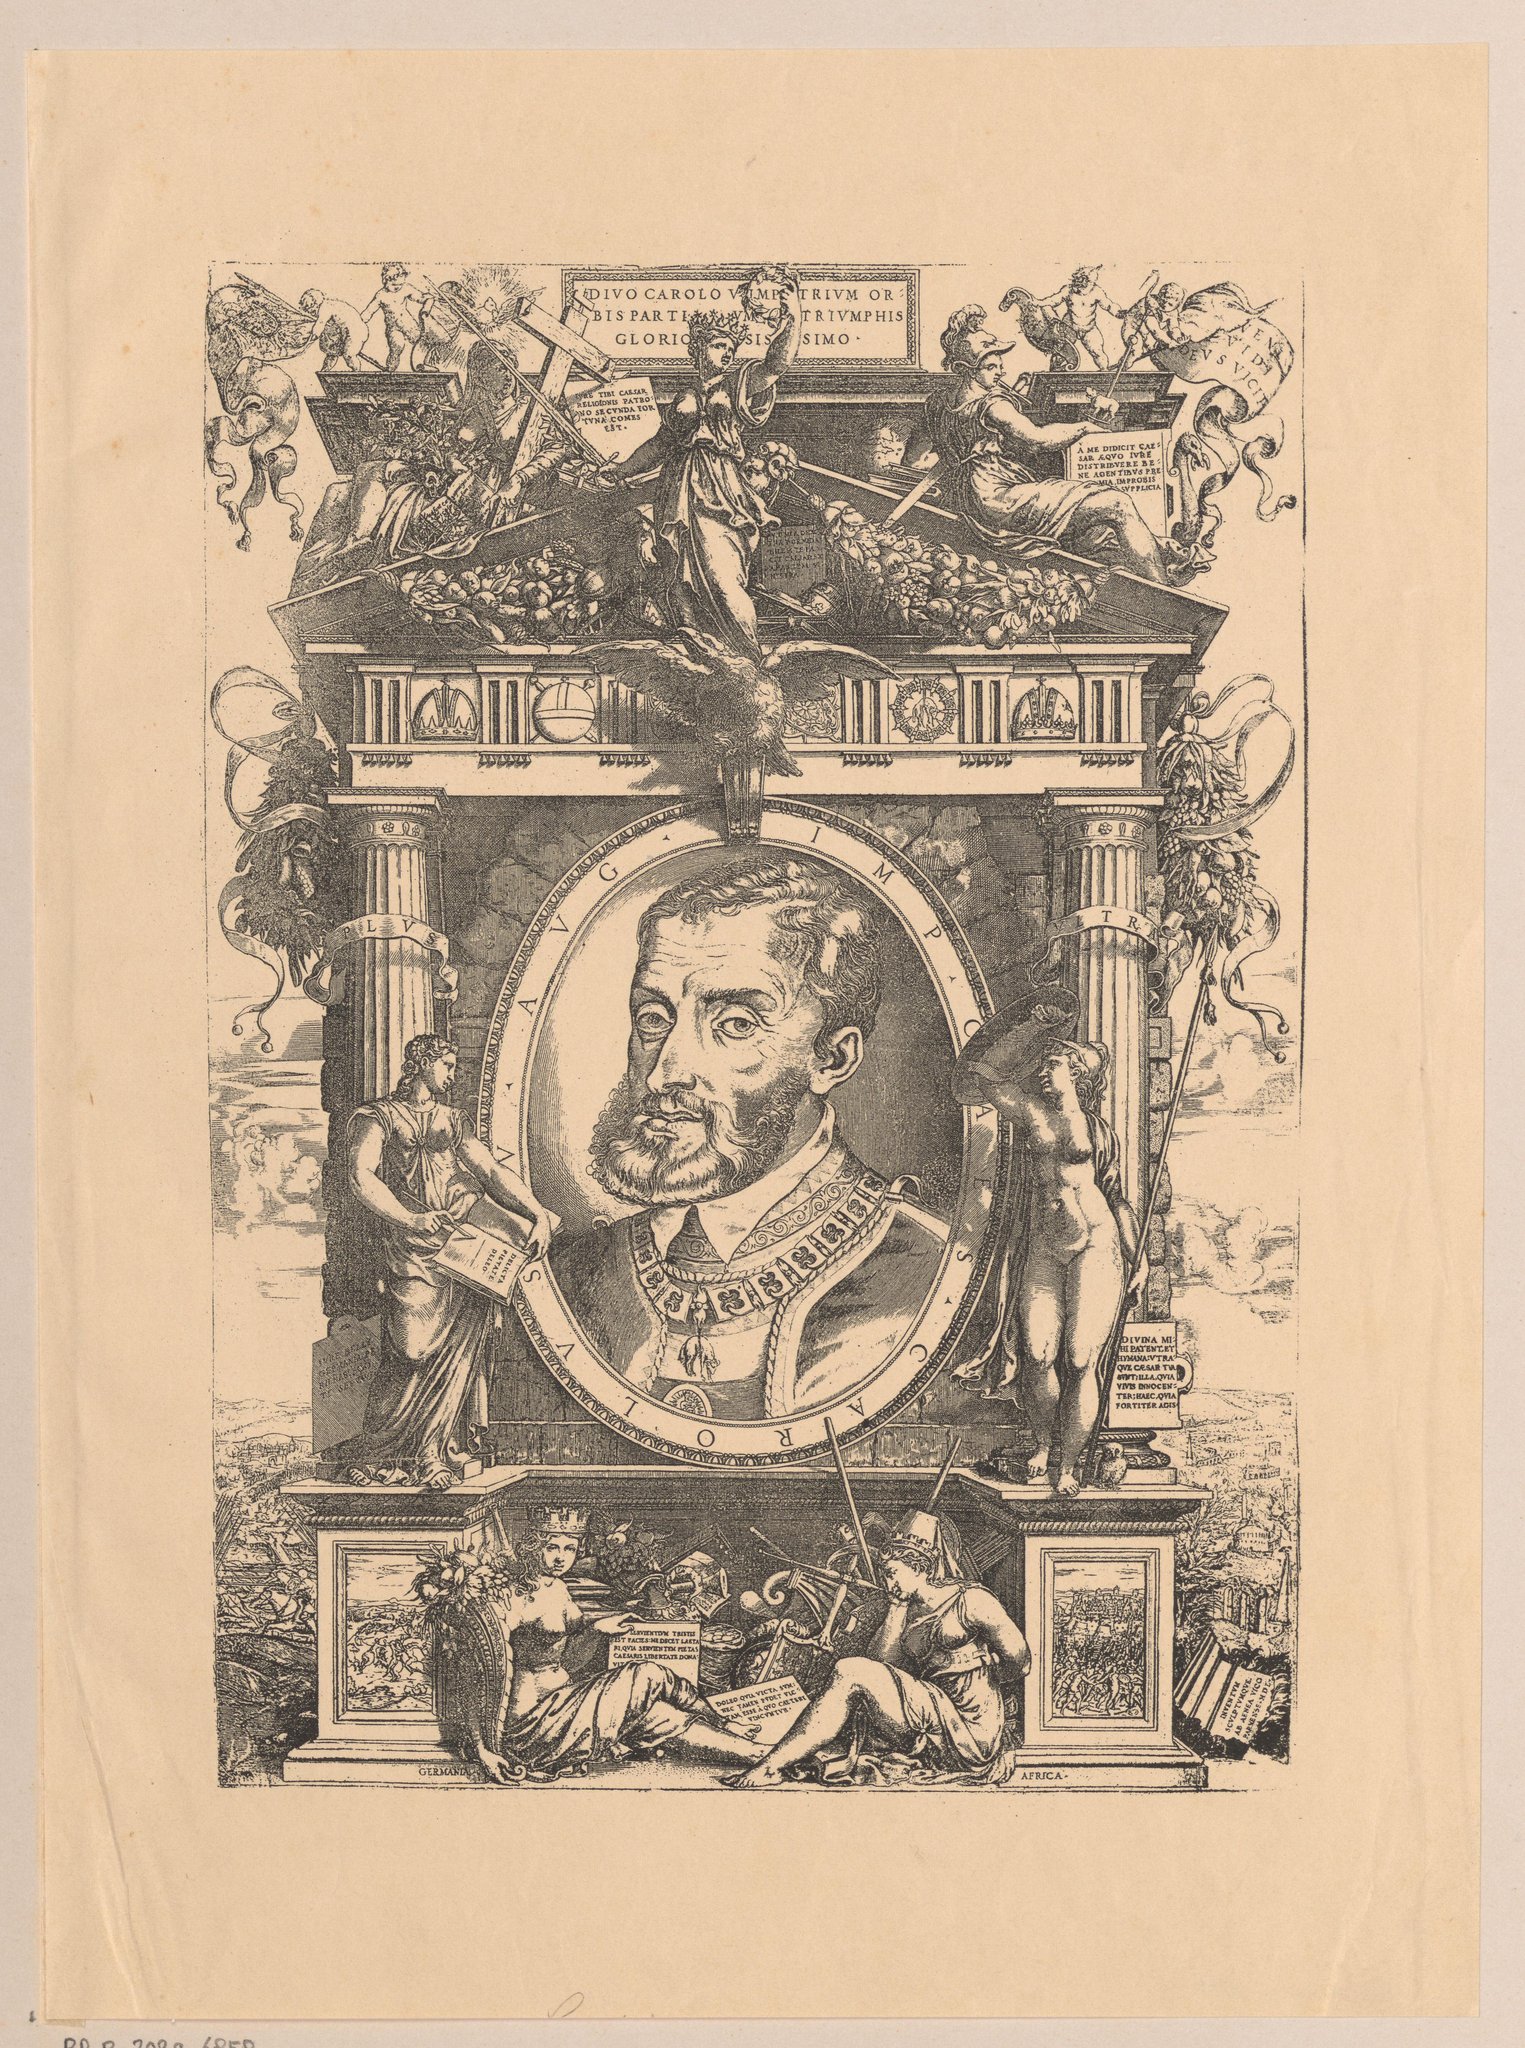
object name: photomechanical print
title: Portret van keizer Karel V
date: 1872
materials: paper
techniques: photolithography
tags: ghent, charles v (holy roman emperor and king of spain), historical persons, knighthood order of the golden fleece, king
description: Prent mogelijk uit: Examples of the Engraved Portraiture of the Sixteenth Century. Londen en Edinburgh: William Stirling Maxwell, 1872.